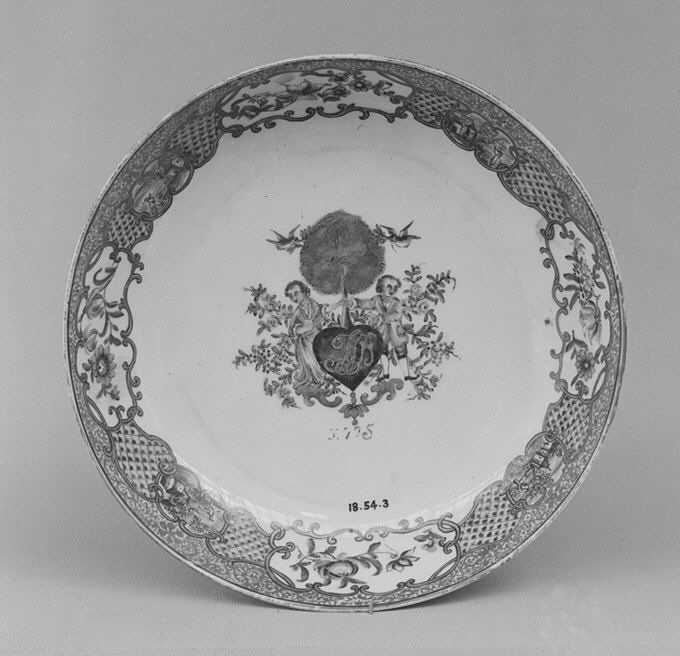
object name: dish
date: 1775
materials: hard paste porcelain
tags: birds,coat of arms